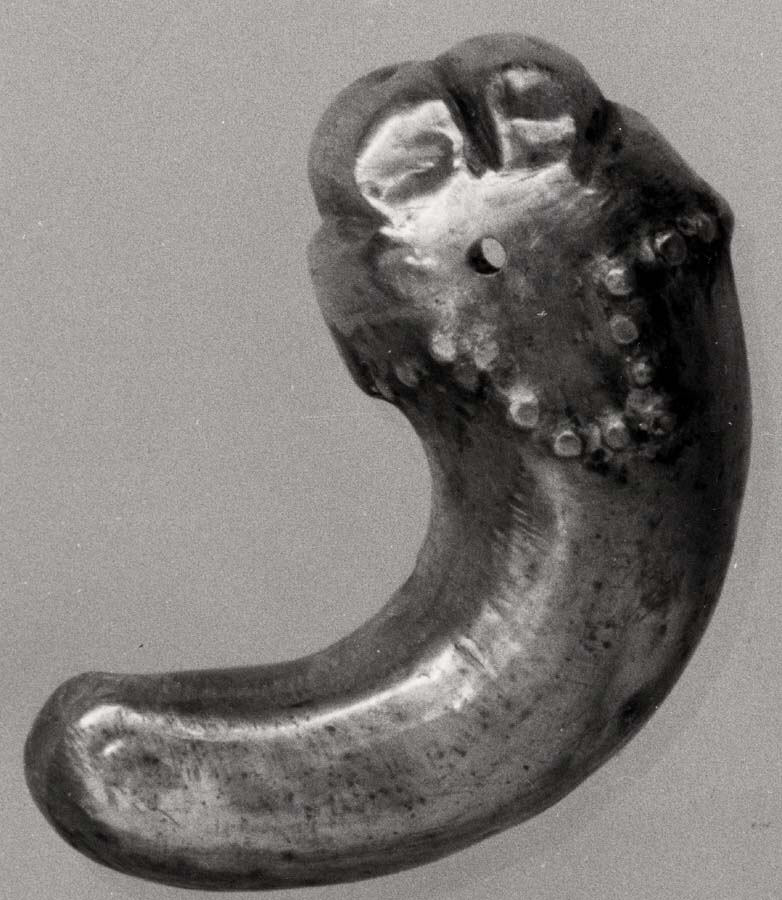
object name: ornament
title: Comma-shaped ornament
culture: korean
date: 501-600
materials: jade, silver